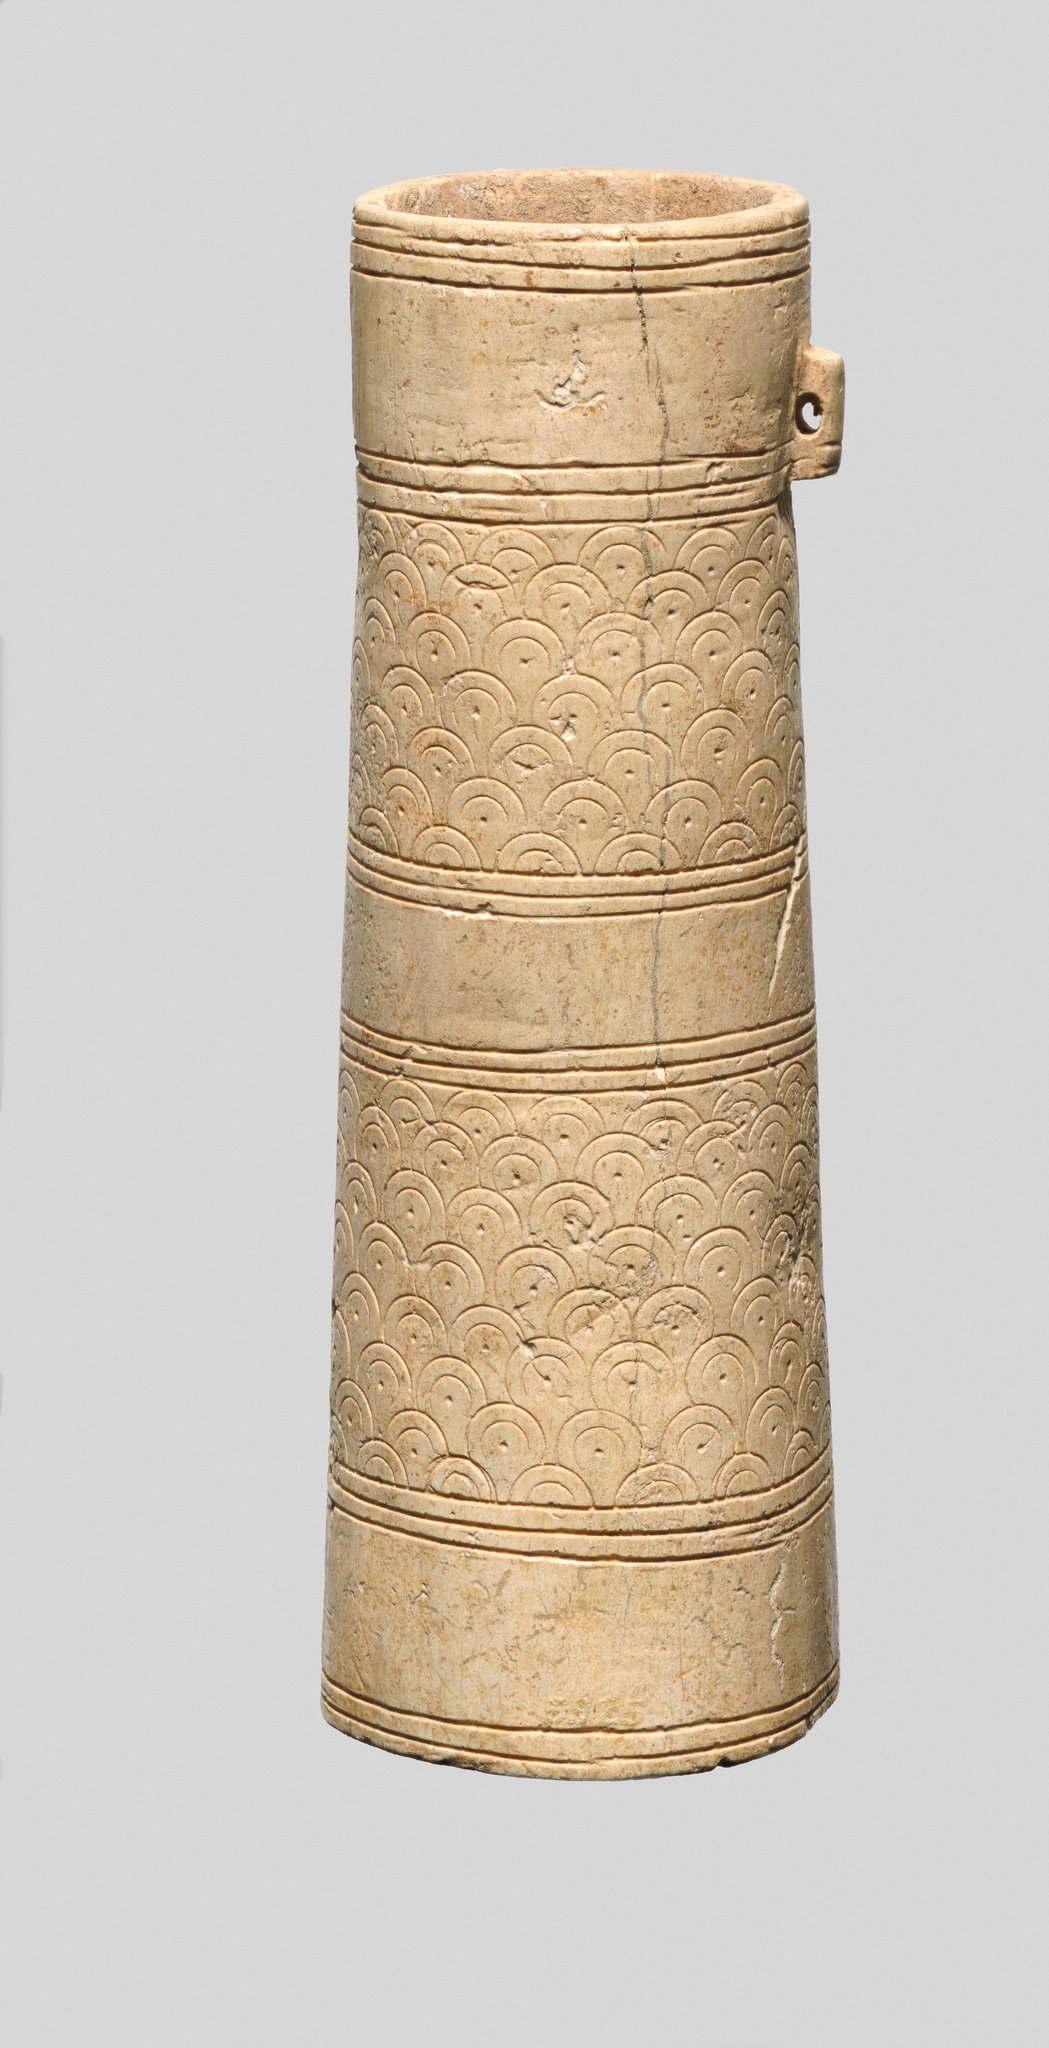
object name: toilet box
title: Narrow bone box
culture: cypriot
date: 1300-1101 BCE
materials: bone